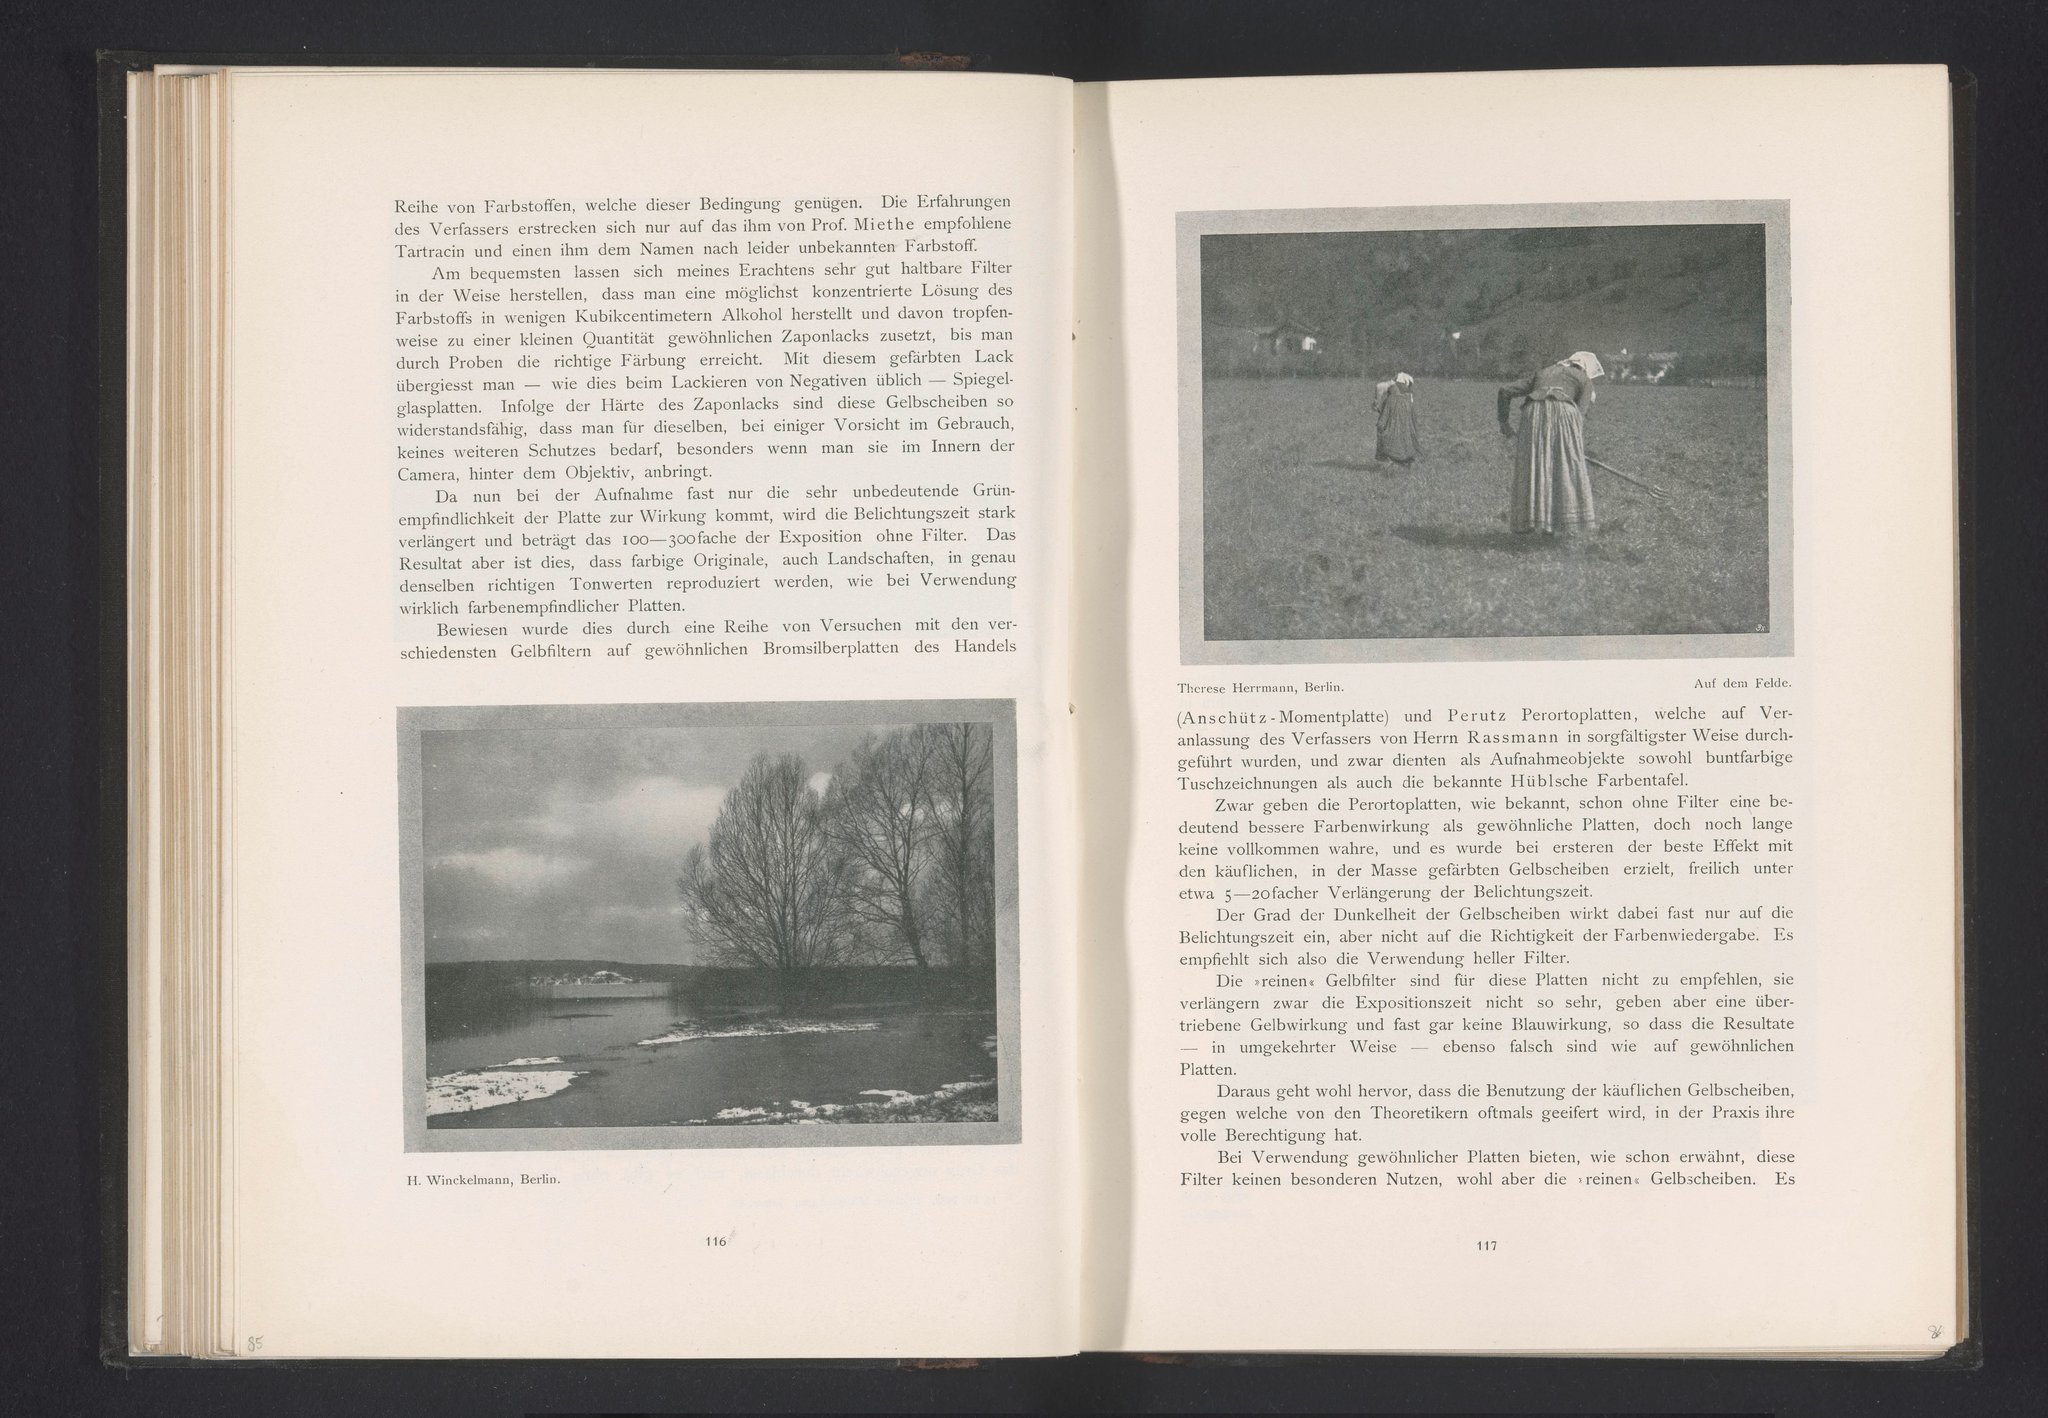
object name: page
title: Twee vrouwen werken op het land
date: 1898-1903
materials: paper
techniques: autotype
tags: agriculture (+ women (labourers))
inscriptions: monogram: ‘BX’, inscription: ‘Berlin’